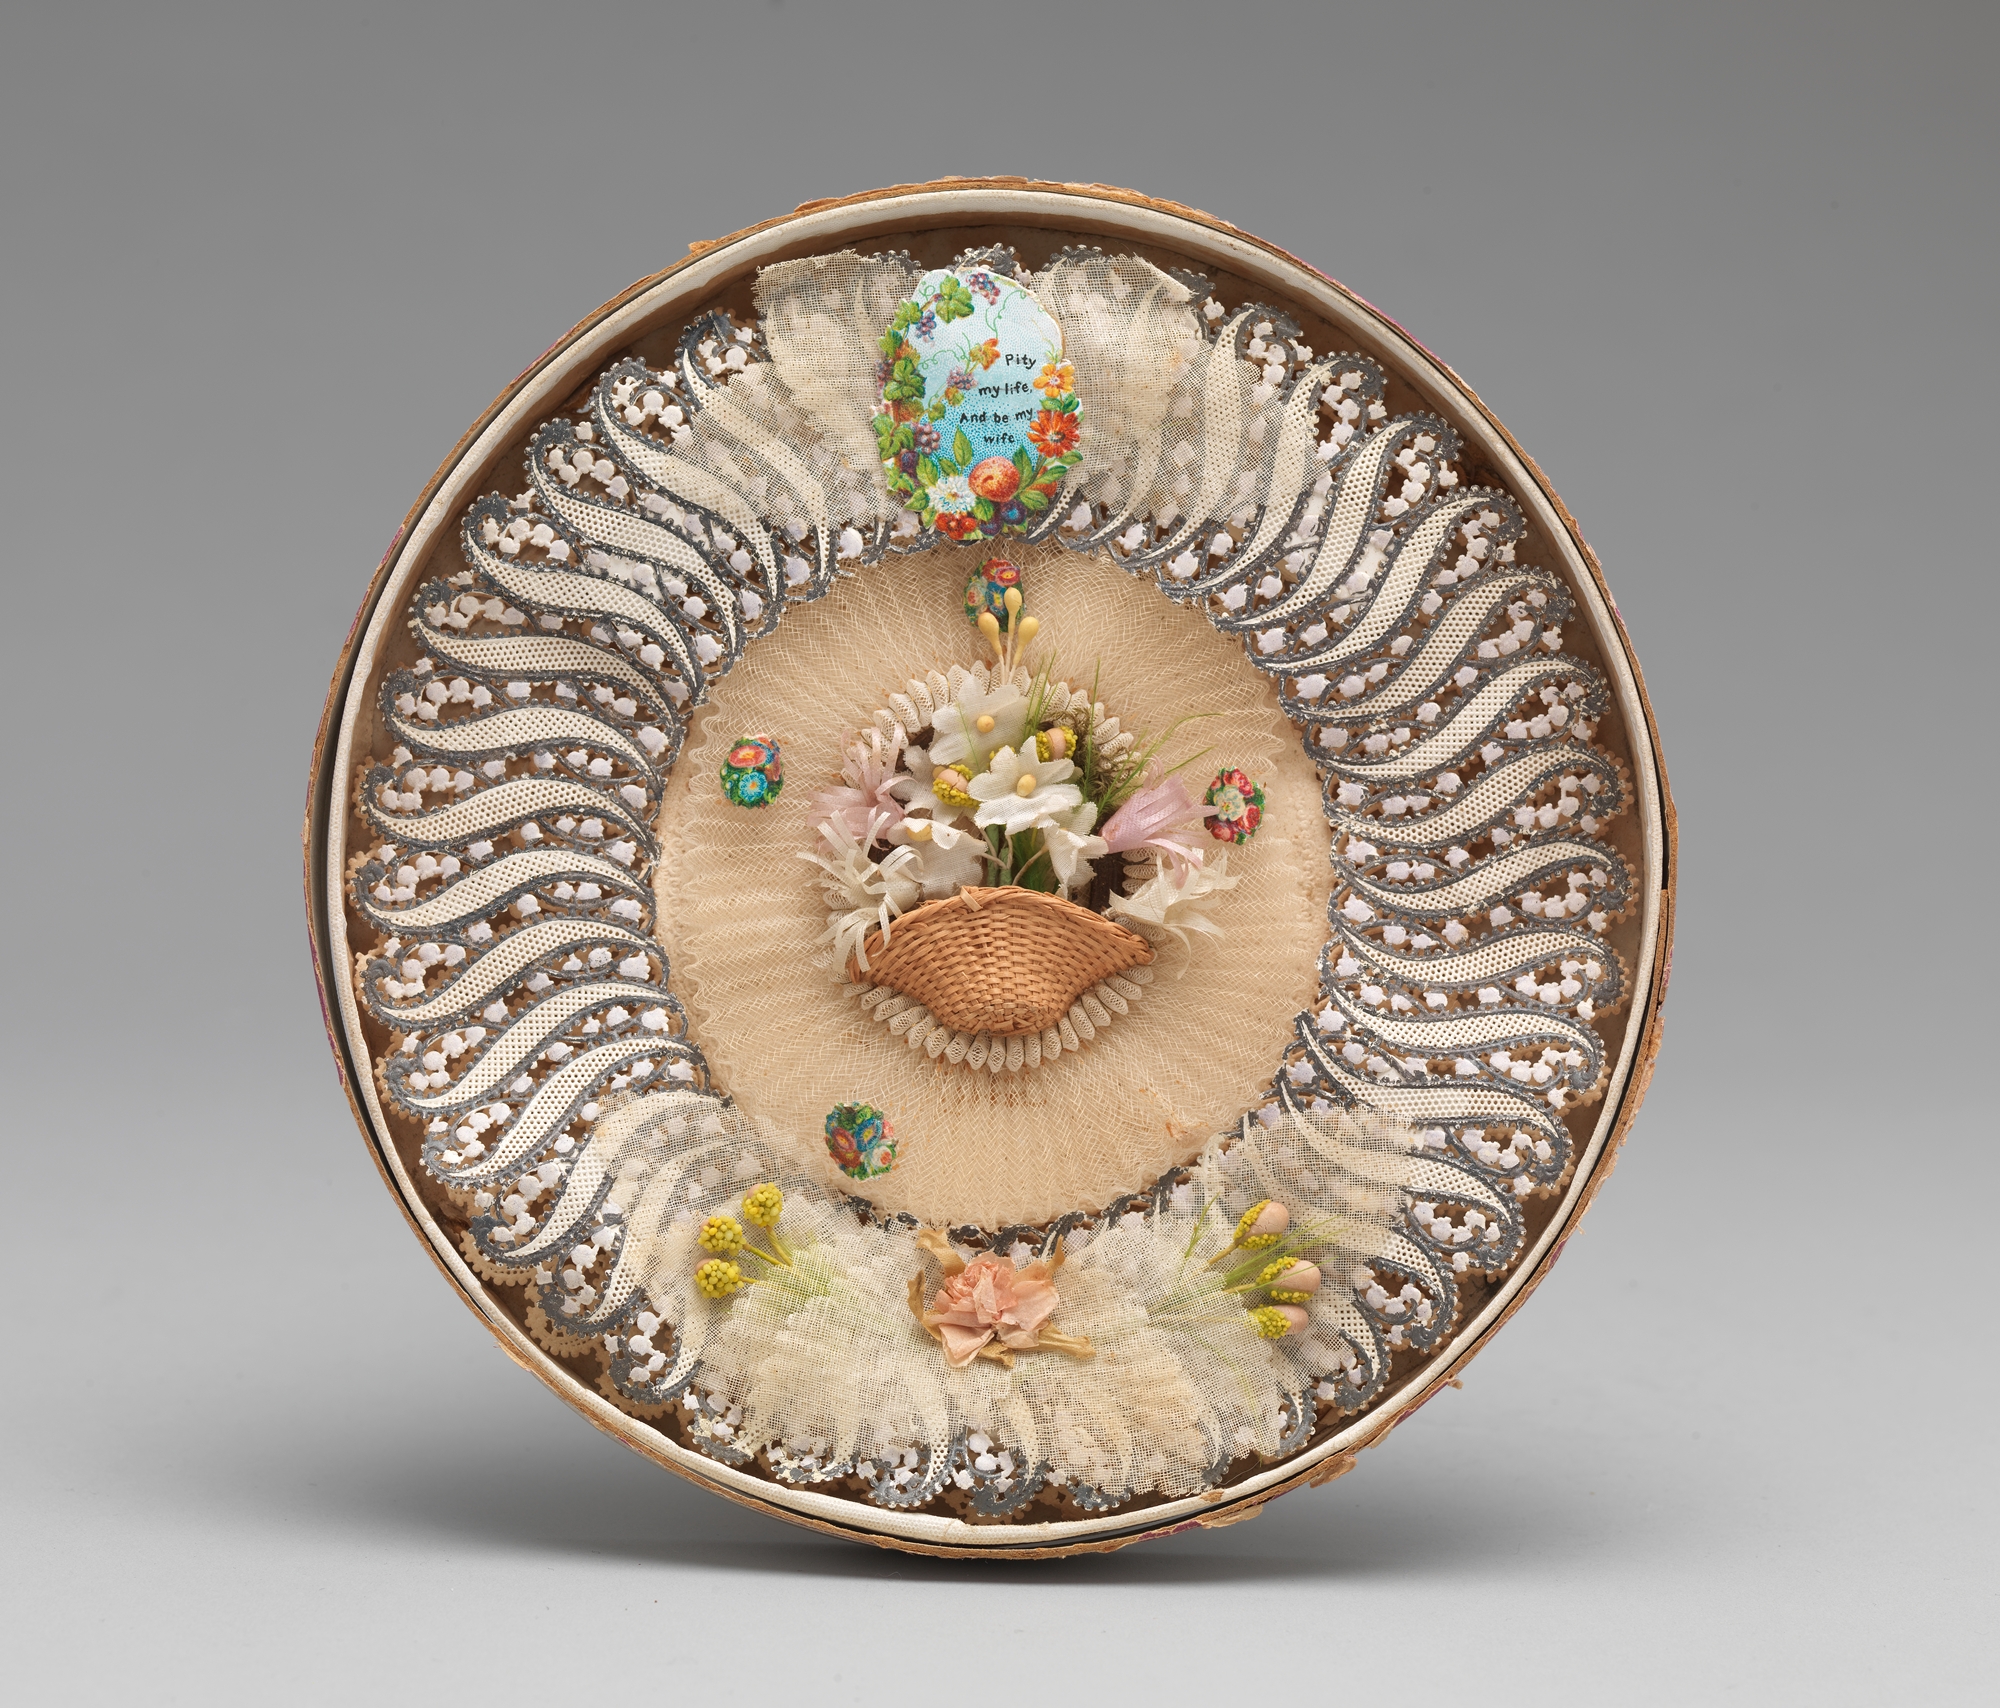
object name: box, card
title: Boxed Valentine's Day Card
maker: anonymous, british, 19th century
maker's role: artist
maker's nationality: british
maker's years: 1800-1900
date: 1840-1899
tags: flowers